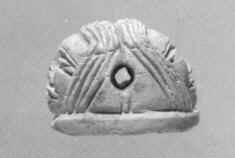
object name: stamp seal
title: Hemispheroid seal with addorsed Egyptianizing human heads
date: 1991-1786 BCE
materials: stone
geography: lebanon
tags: heads